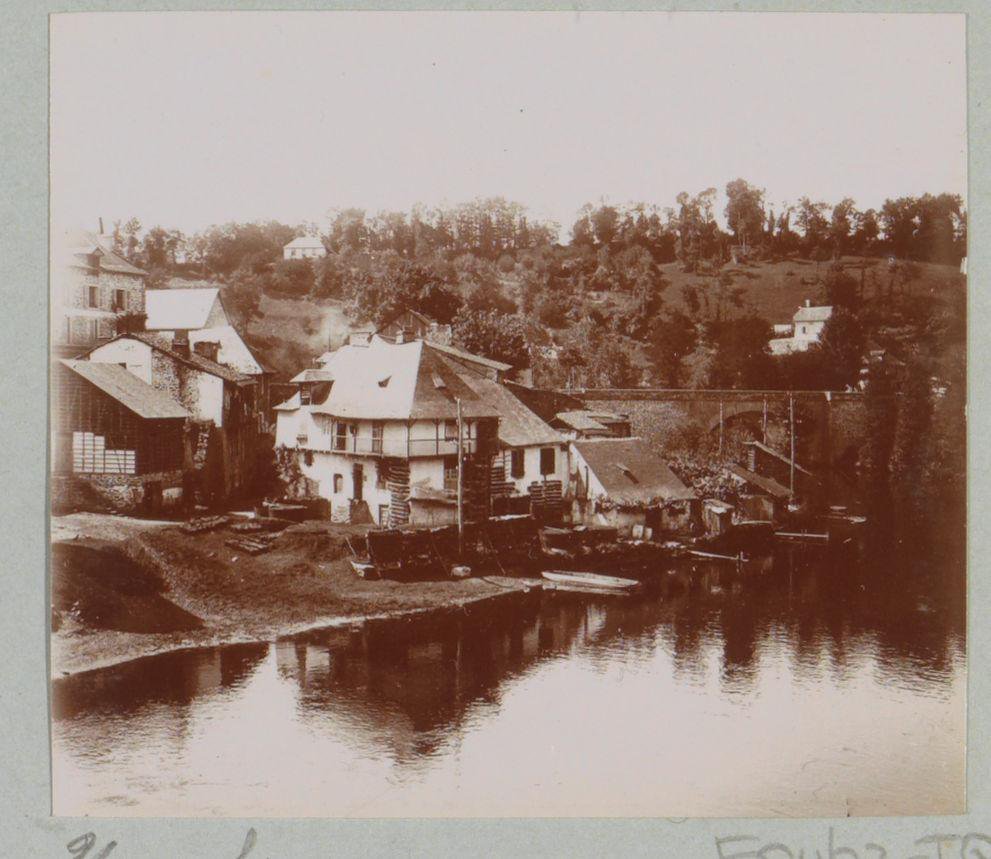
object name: photograph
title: Gezicht op Uzerche aan de Vézère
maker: delizy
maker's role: manufacturer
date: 1903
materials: paper, photographic support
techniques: gelatin silver print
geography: uzerche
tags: prospect of village, silhouette of village, river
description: Onderdeel van Fotoalbum van een Franse amateurfotograaf met opnames van uitstapjes in Frankrijk, Spanje, België, Luxemburg en Nederland, de eerste automobielen en autoraces.